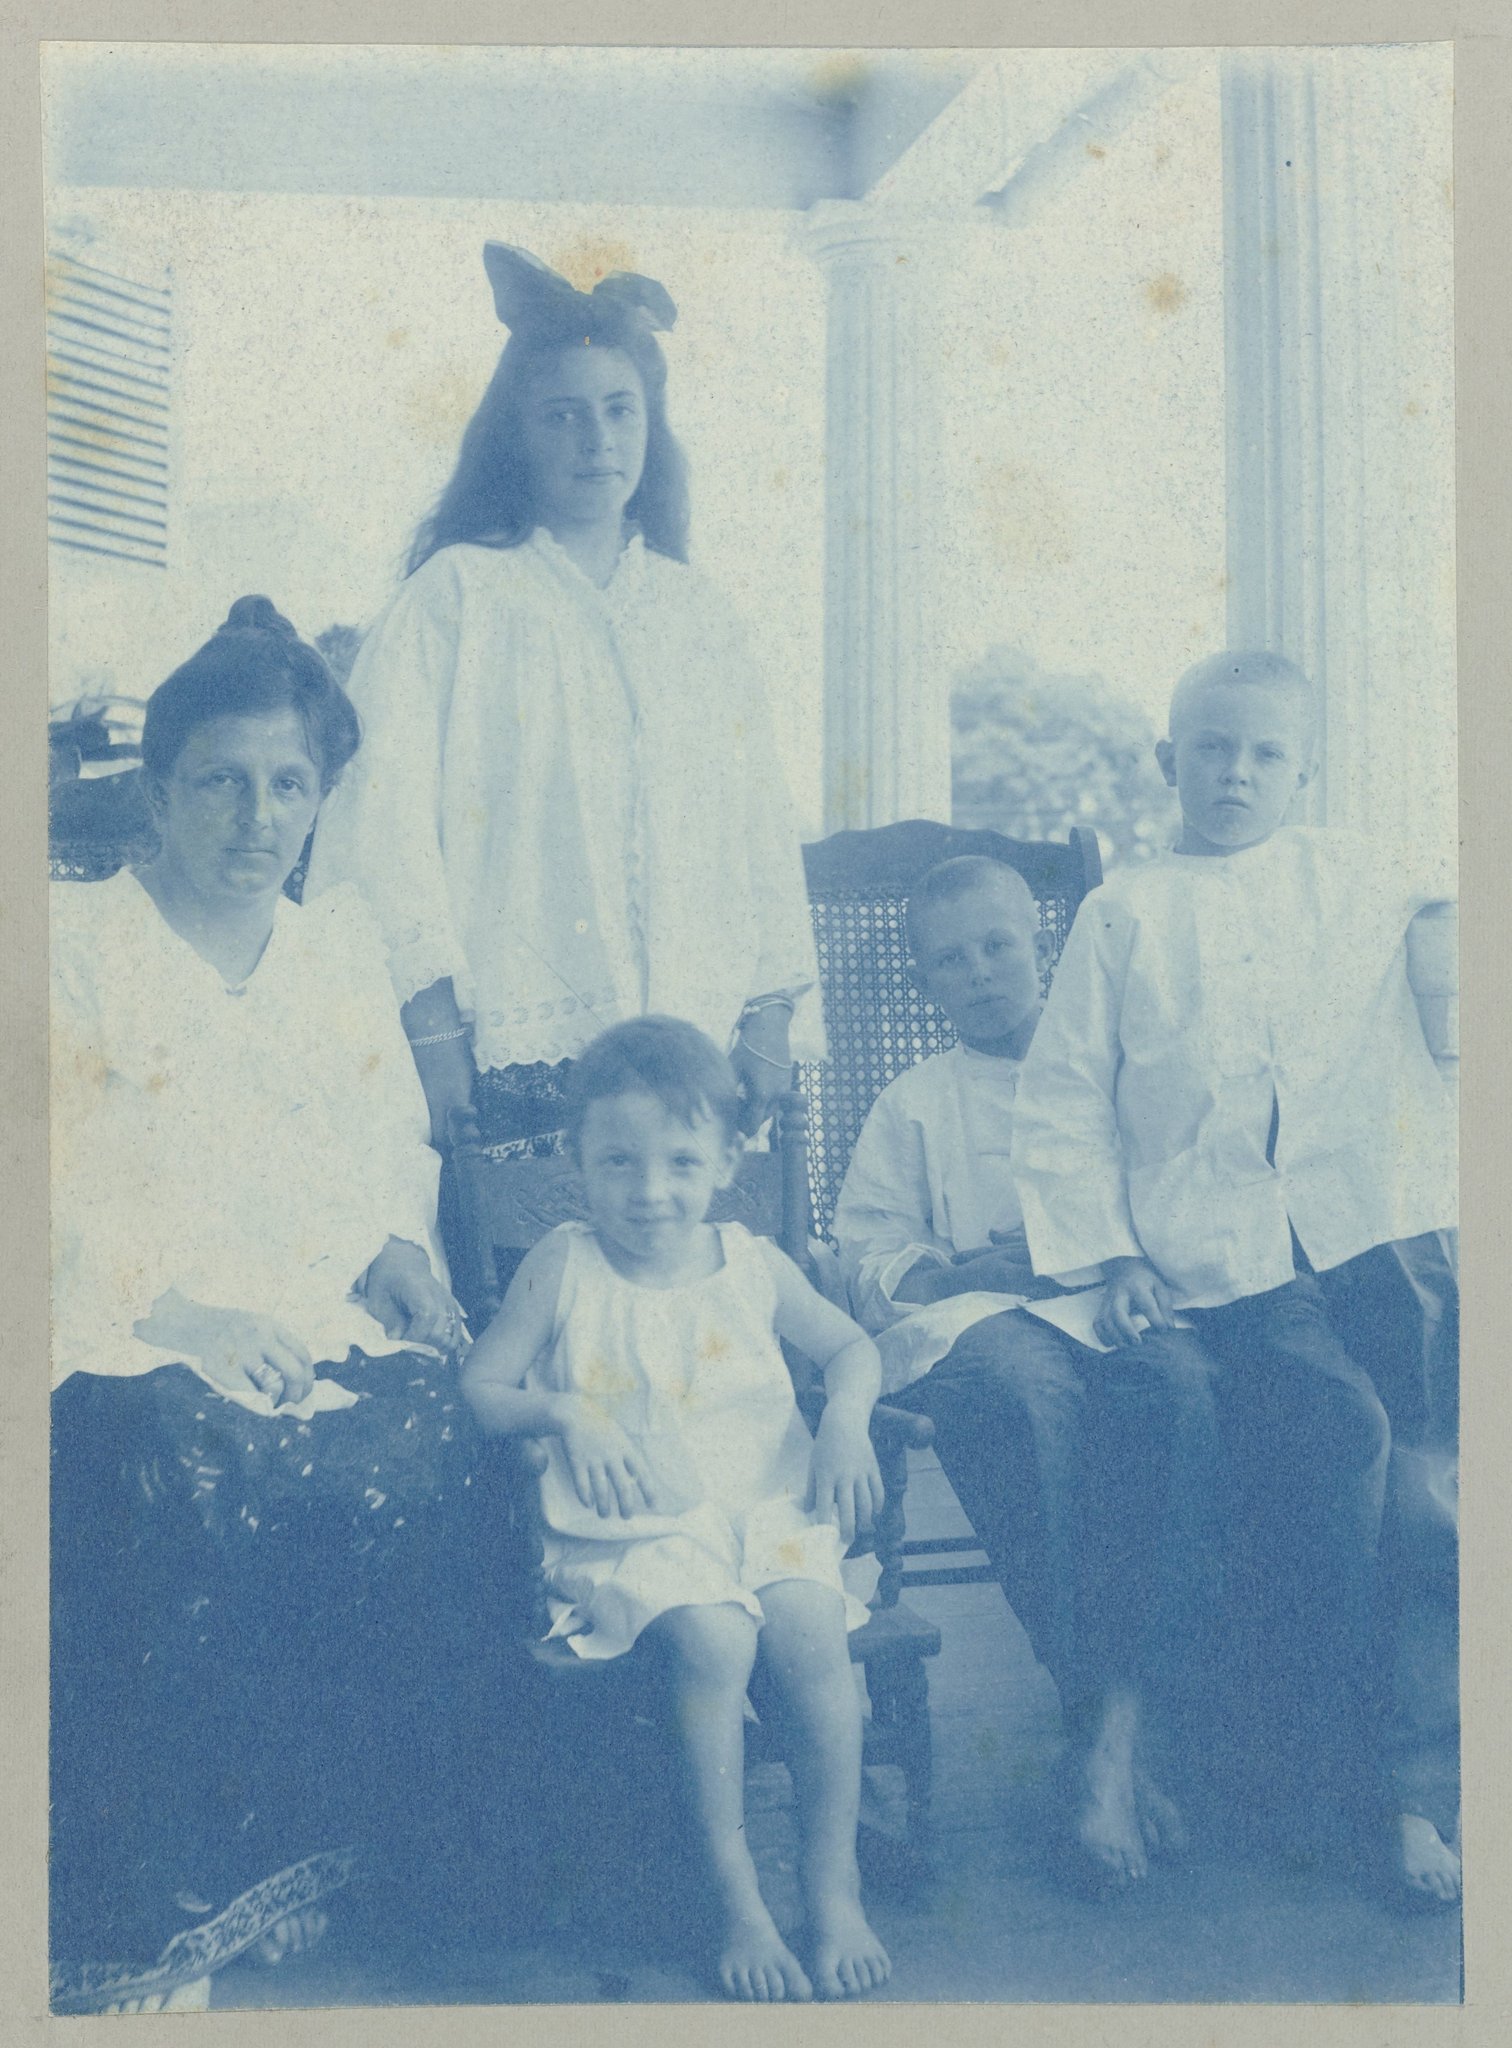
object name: photograph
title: Op het balkon in de Oranjestraat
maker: hendrik doijer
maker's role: engineer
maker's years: 1863-1925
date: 1903-1910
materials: photographic support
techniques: cyanotype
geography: suriname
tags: suriname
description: Familiefoto van moeder met dochter en drie zoons (van de familie Doijer?) op het balkon van het huis in de Oranjestraat te Paramaribo. Onderdeel van het fotoalbum Souvenir de Voyage (deel 2), over het leven van de familie Doijer in en rond de plantage Ma Retraite in Suriname in de jaren 1903-1910.